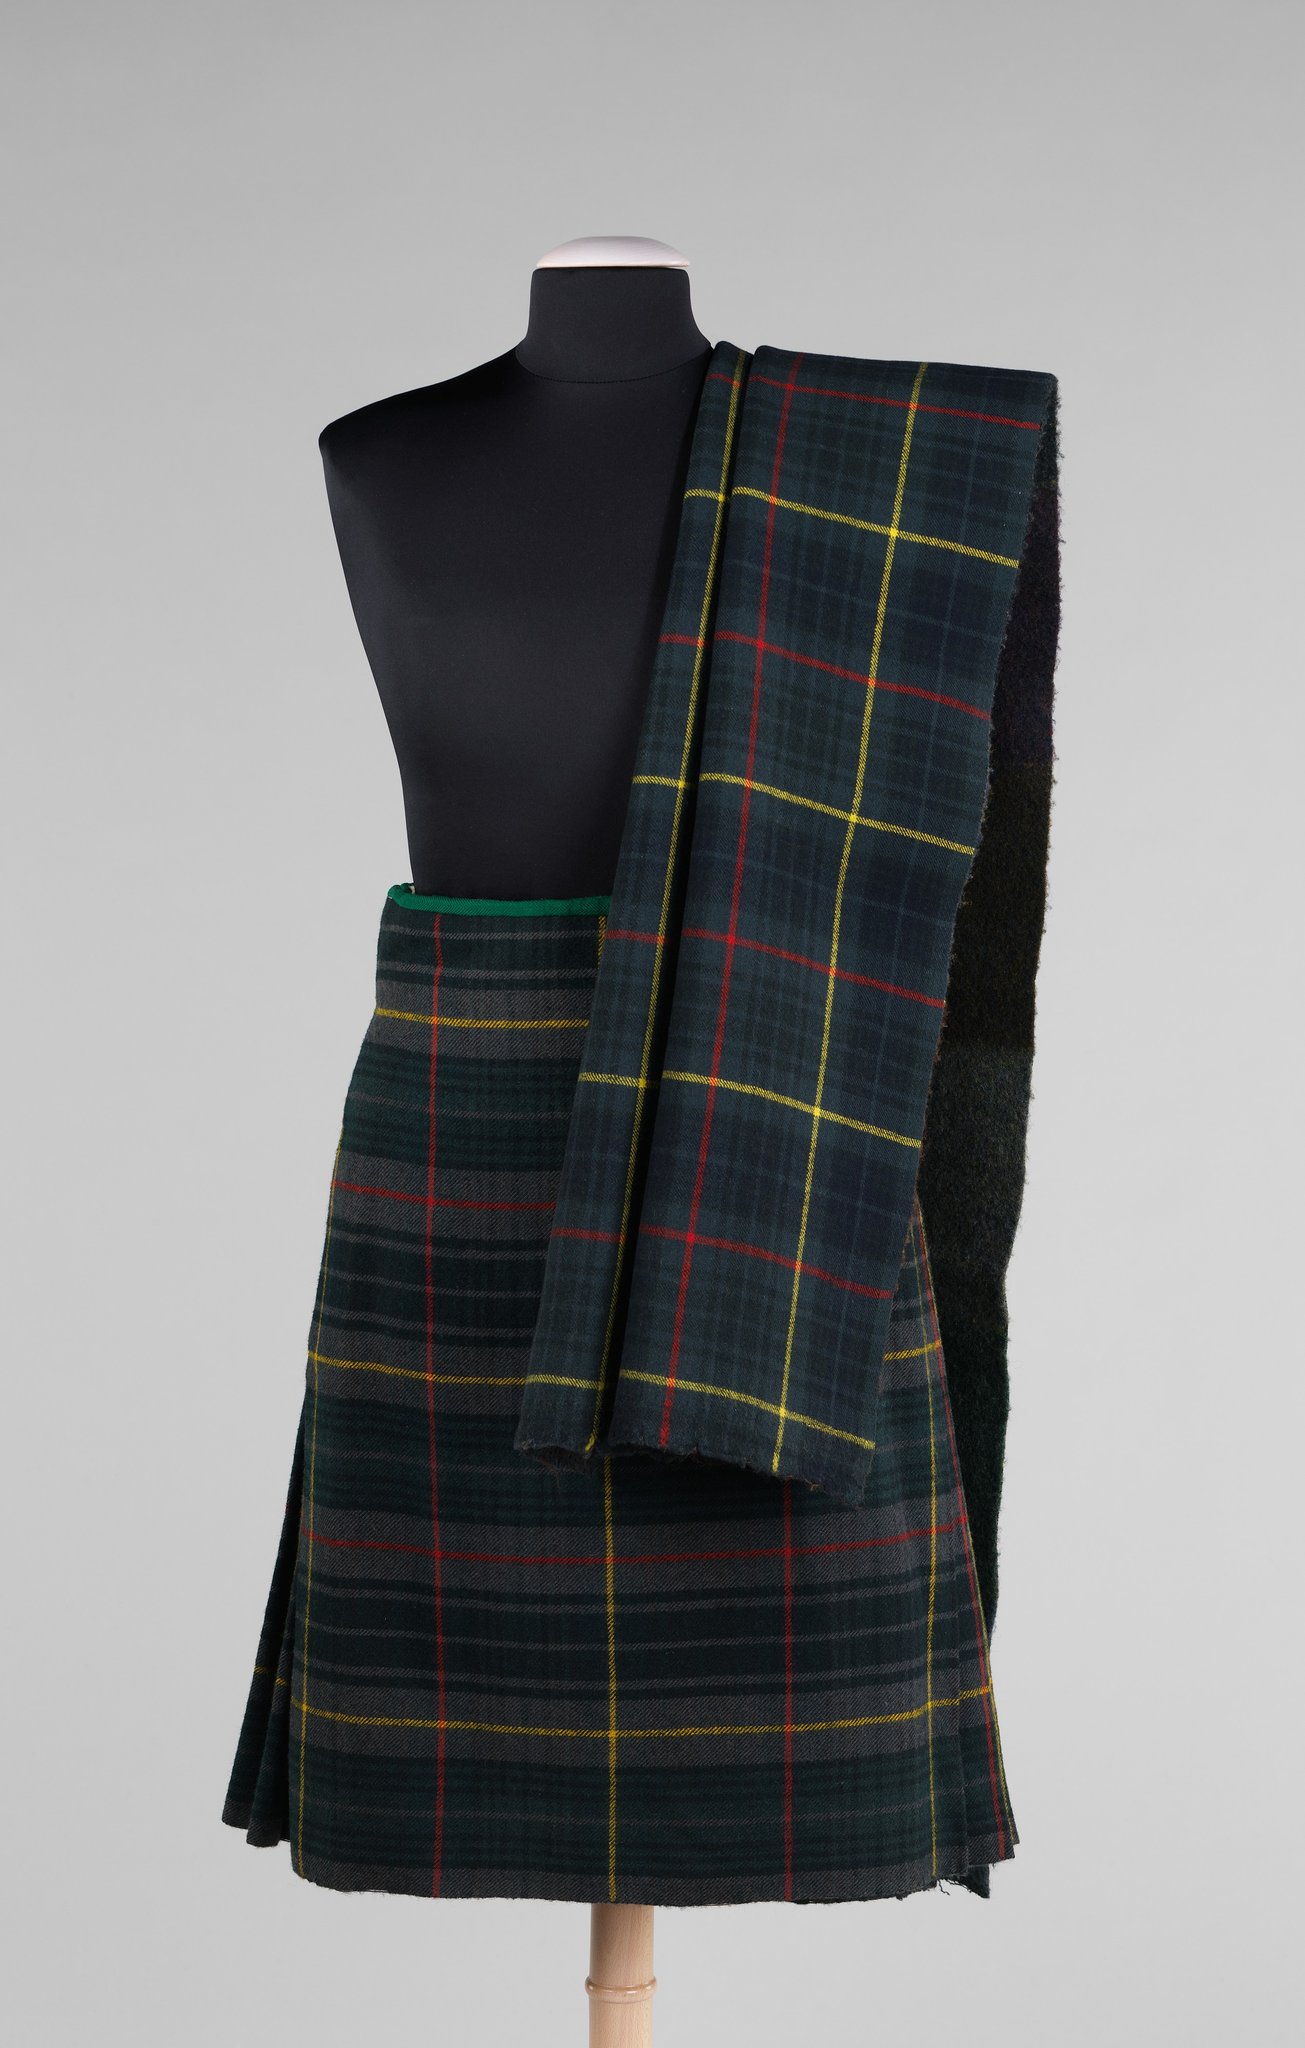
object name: kilt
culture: scottish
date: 1867-1900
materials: leather, metal, wool